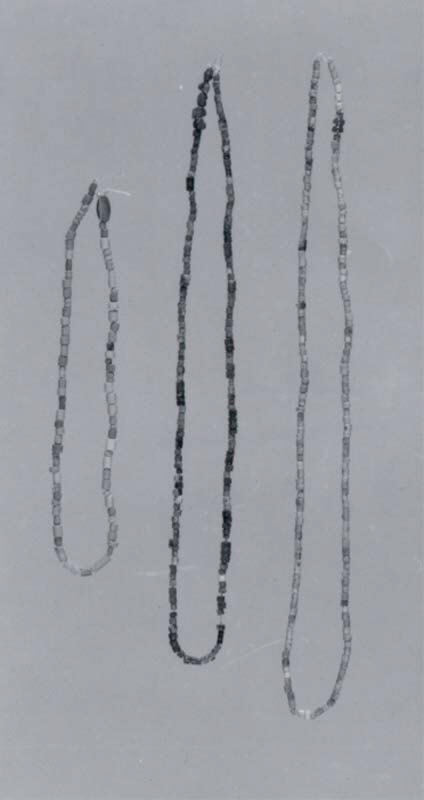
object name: bead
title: Beads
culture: iranian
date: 900-801 BCE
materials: faience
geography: iran